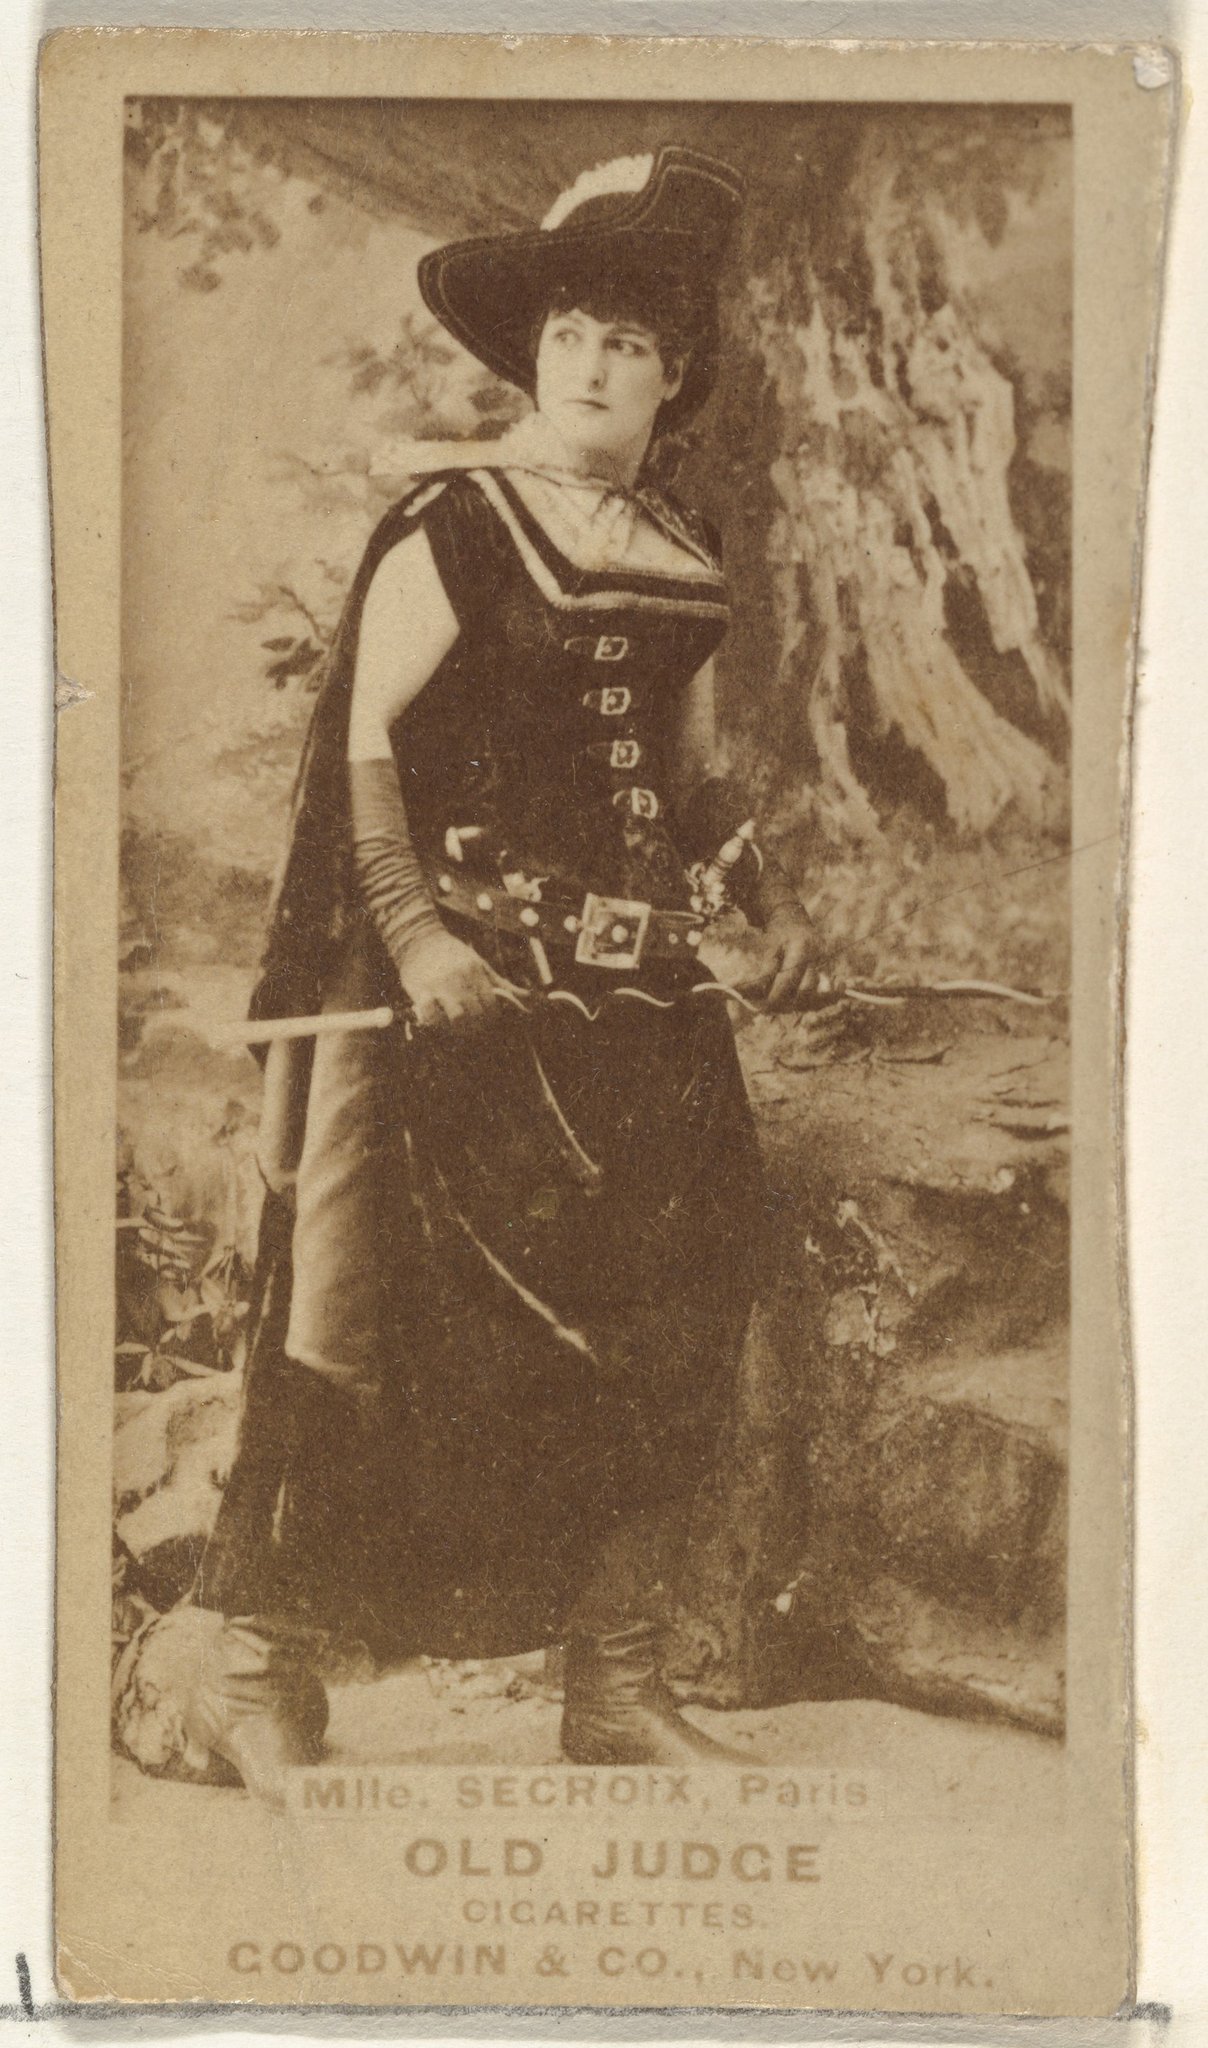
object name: photograph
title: Mlle. Secroix, Paris, from the Actors and Actresses series (N171) for Old Judge Cigarettes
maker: goodwin & company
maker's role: publisher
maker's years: 1850-1950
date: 1886-1890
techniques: albumen silver print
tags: portraits,women,actresses